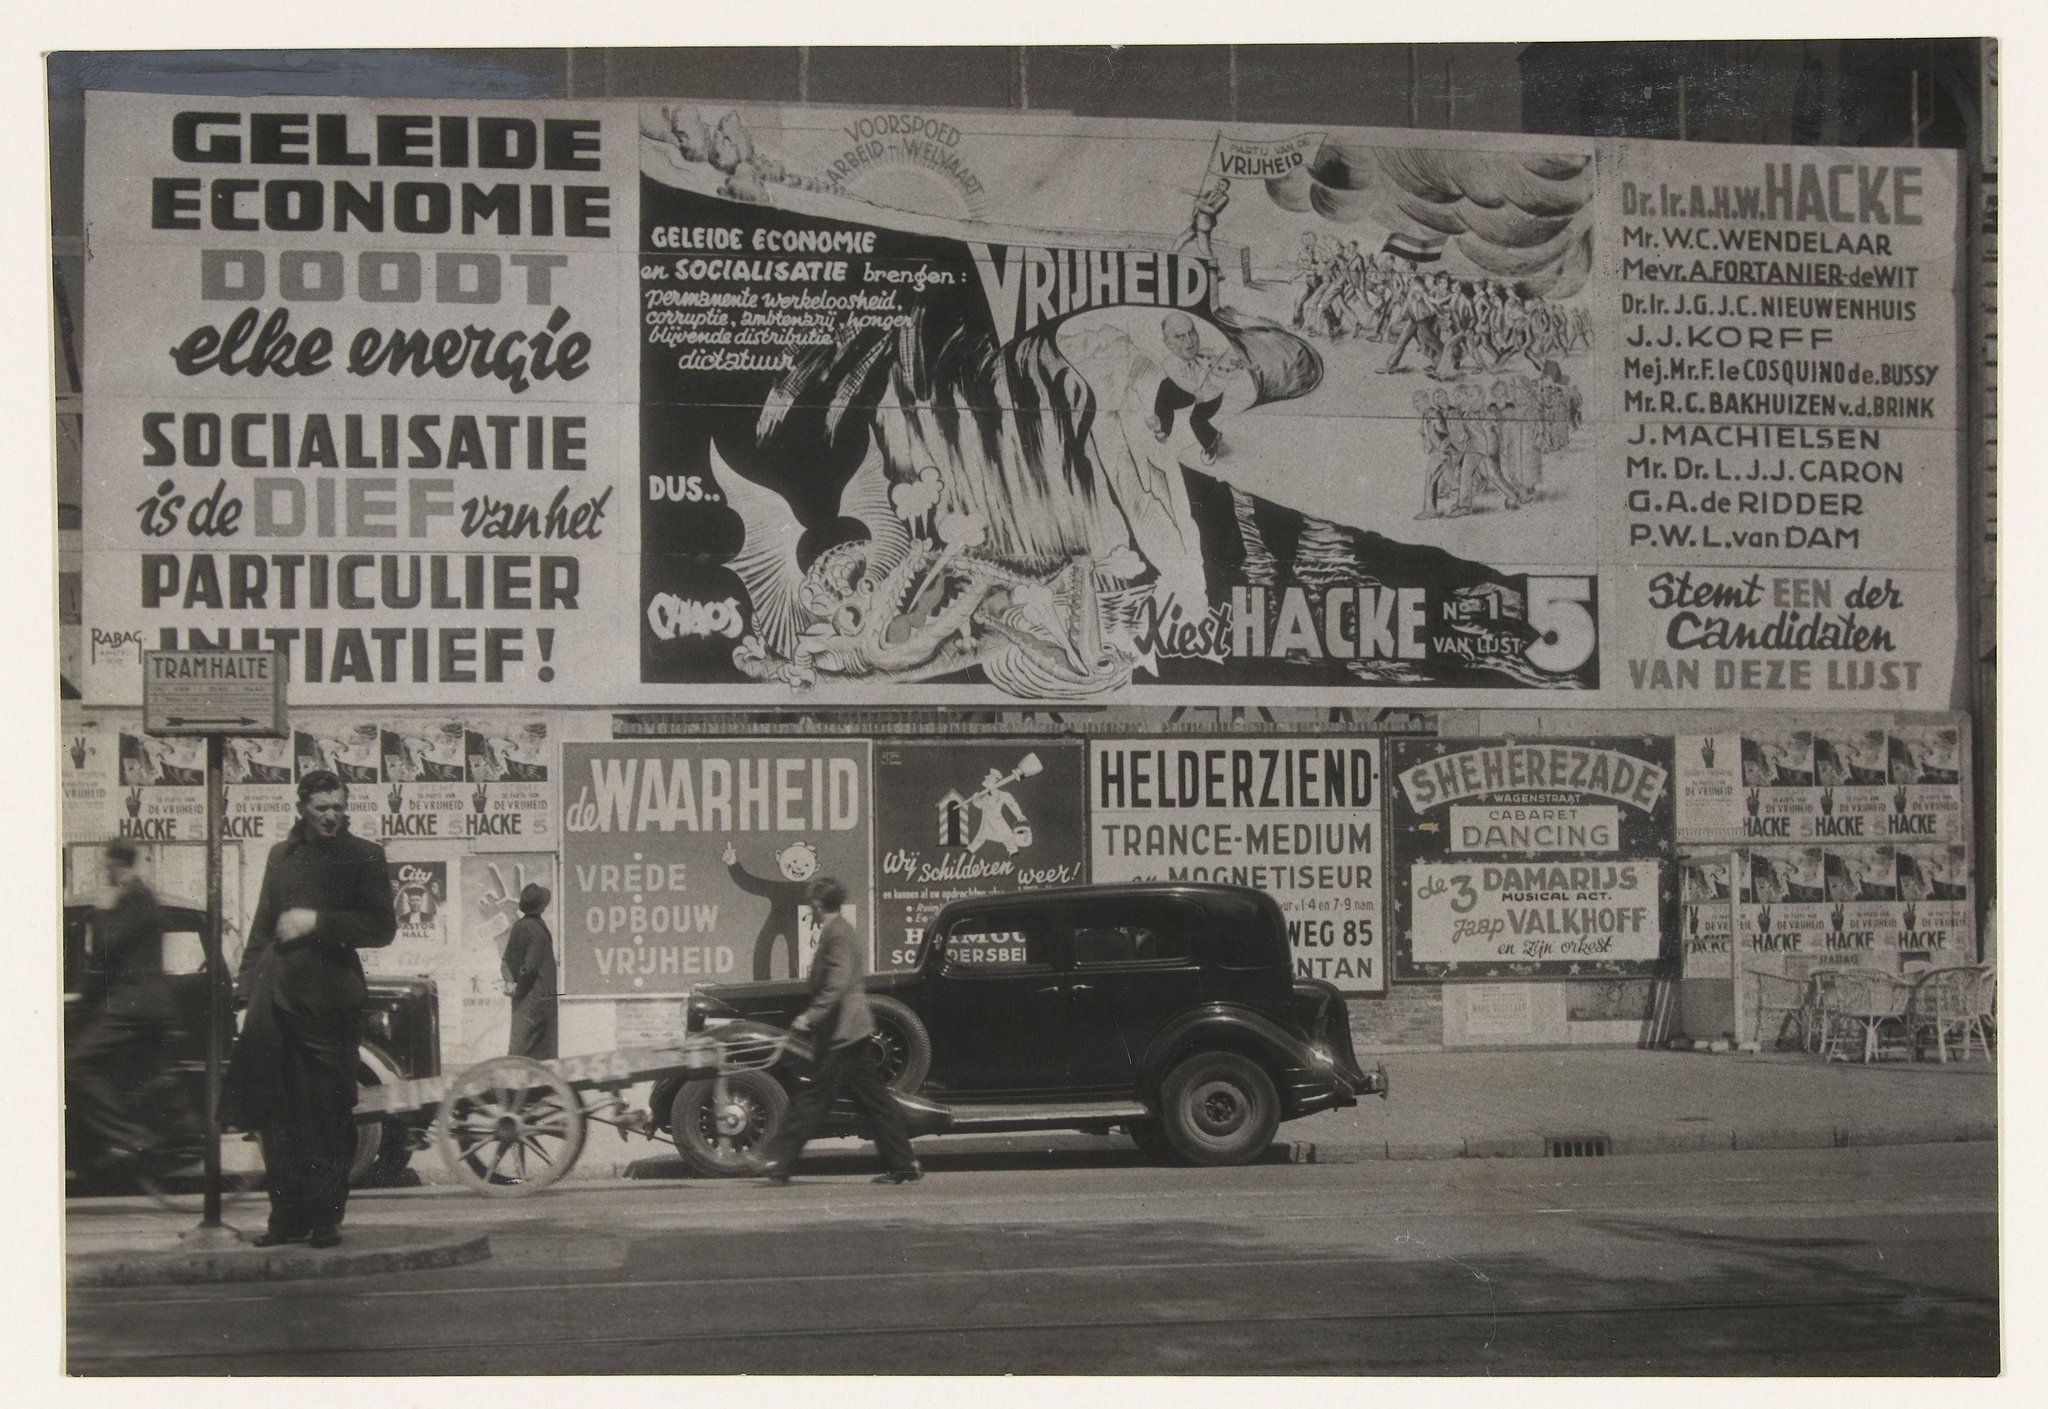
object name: documentary photograph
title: Straat met een beplakte muur met affiches van de Partij van de Vrijheid voor de landelijke verkiezingen van 1946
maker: Anonymous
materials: photographic support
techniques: photography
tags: publisher, amsterdam, politician, den helder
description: Straat met een fietser, een geparkeerde auto, een man met handkar, en een wachtende reiziger bij een tramhalte tegen een muur met daarop politieke affiches en reclameposters. Het gaat om affiches voor de landelijke verkiezingen van 16 mei 1946 en het meest in het oog springend is een meer dan levensgrote affiche van de Partij van de Vrijheid. Met de slagzin: 'Geleide economie doodt elke energie. Socialisatie is de dief van het particulier initiatief.' De tekening op het affiche sluit nauw aan bij de slagzin en toont in contrast de chaos (verderf) en de vrijheid (welvaart). Met als de lijsttrekker van lijst 5 de heer A.H.W. Hacke voor de kieskringen Amsterdam en Den Helder.